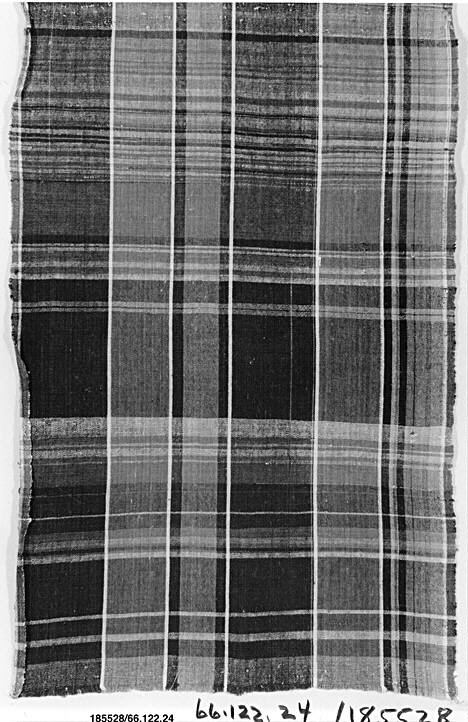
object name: piece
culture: japanese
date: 1801-1900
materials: cotton, silk